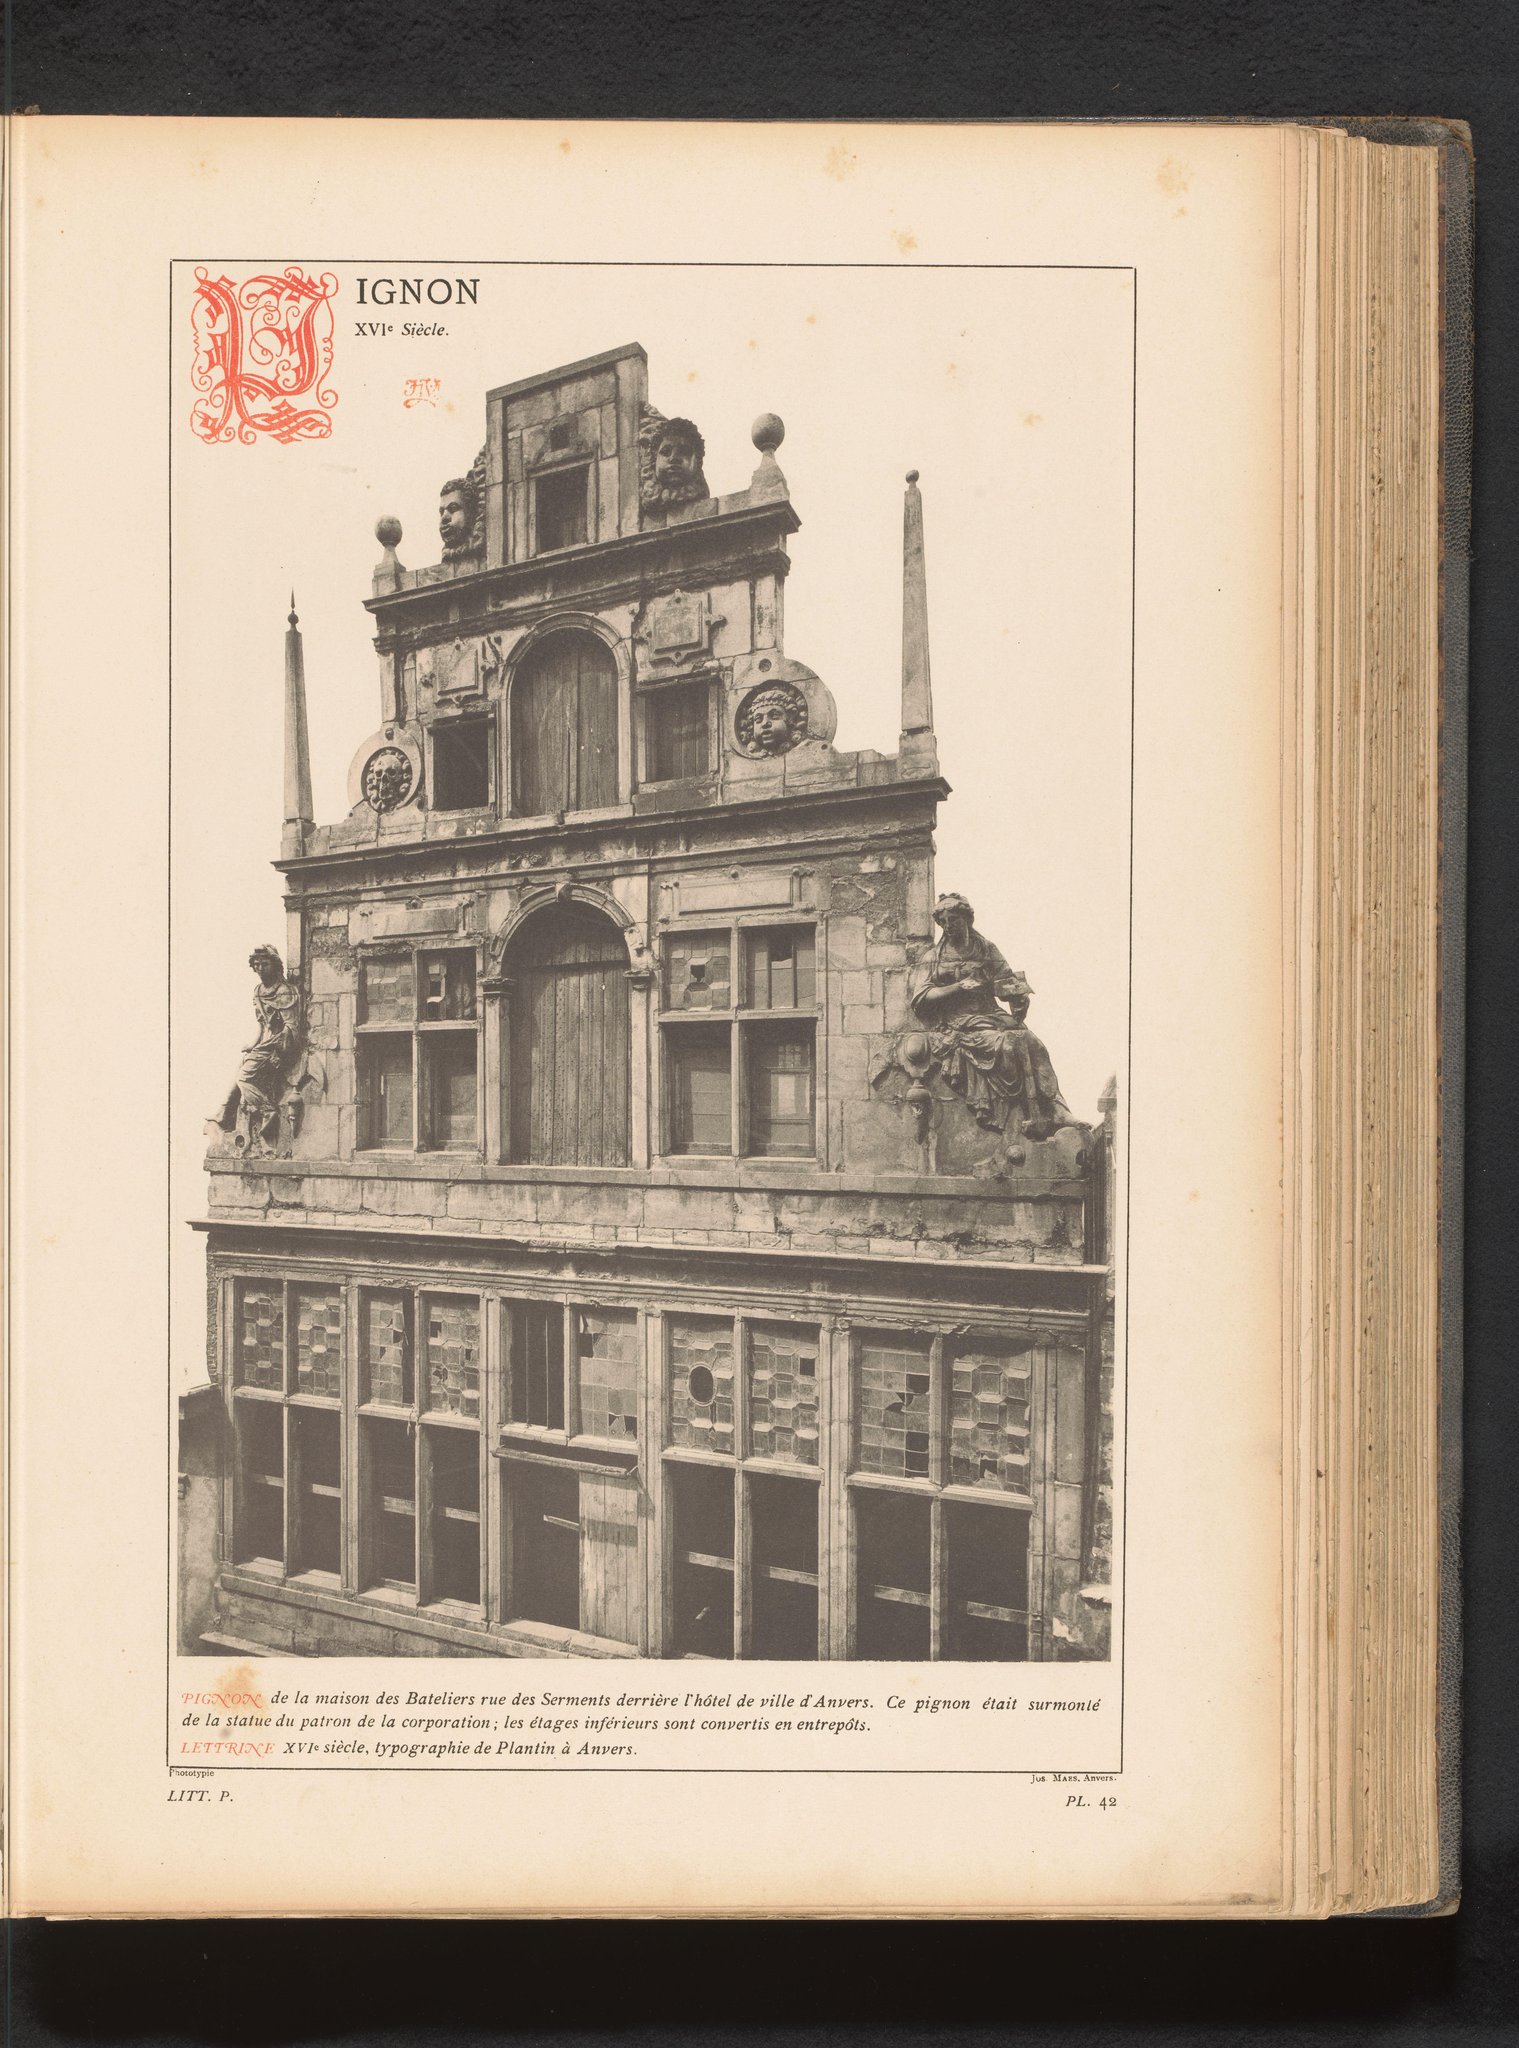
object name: photomechanical print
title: Pignon, XVIe Siècle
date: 1876-1881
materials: paper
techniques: photograph, photolithography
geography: antwerp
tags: decorated gable, antwerp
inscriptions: inscription: ‘LITT. P. - PL. 42.’, inscription: ‘PIGNON de la maison (...)’, monogram: ‘JJvY’